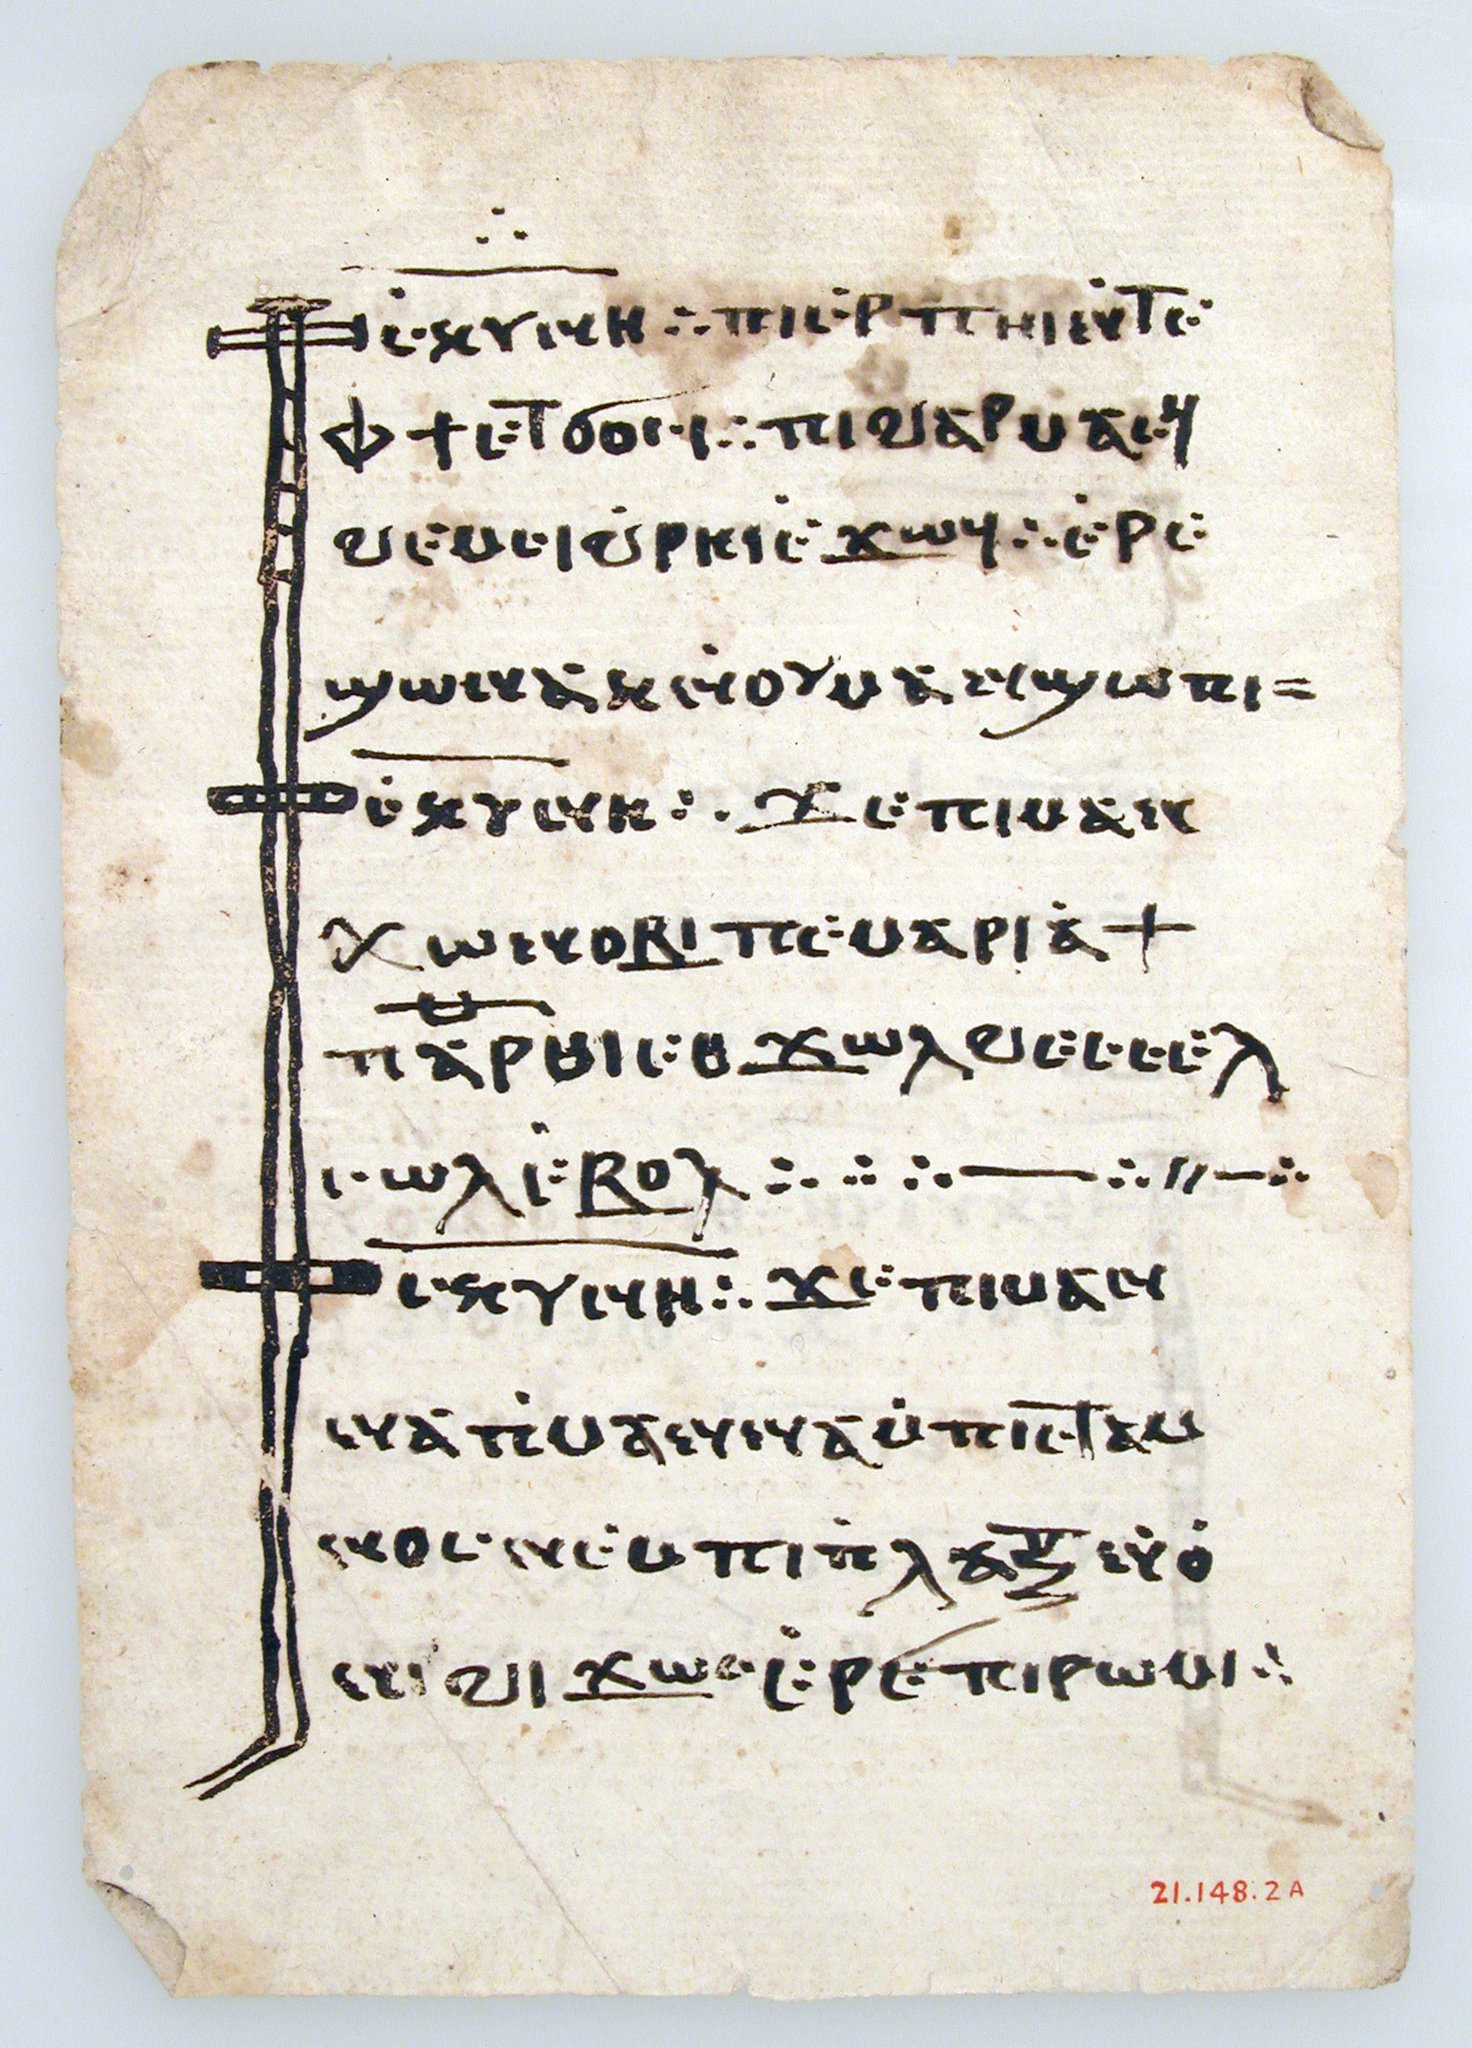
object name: manuscript leaf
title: Leaves from a Coptic Manuscript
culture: coptic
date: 501-1400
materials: ink, paper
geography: egypt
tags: coptic